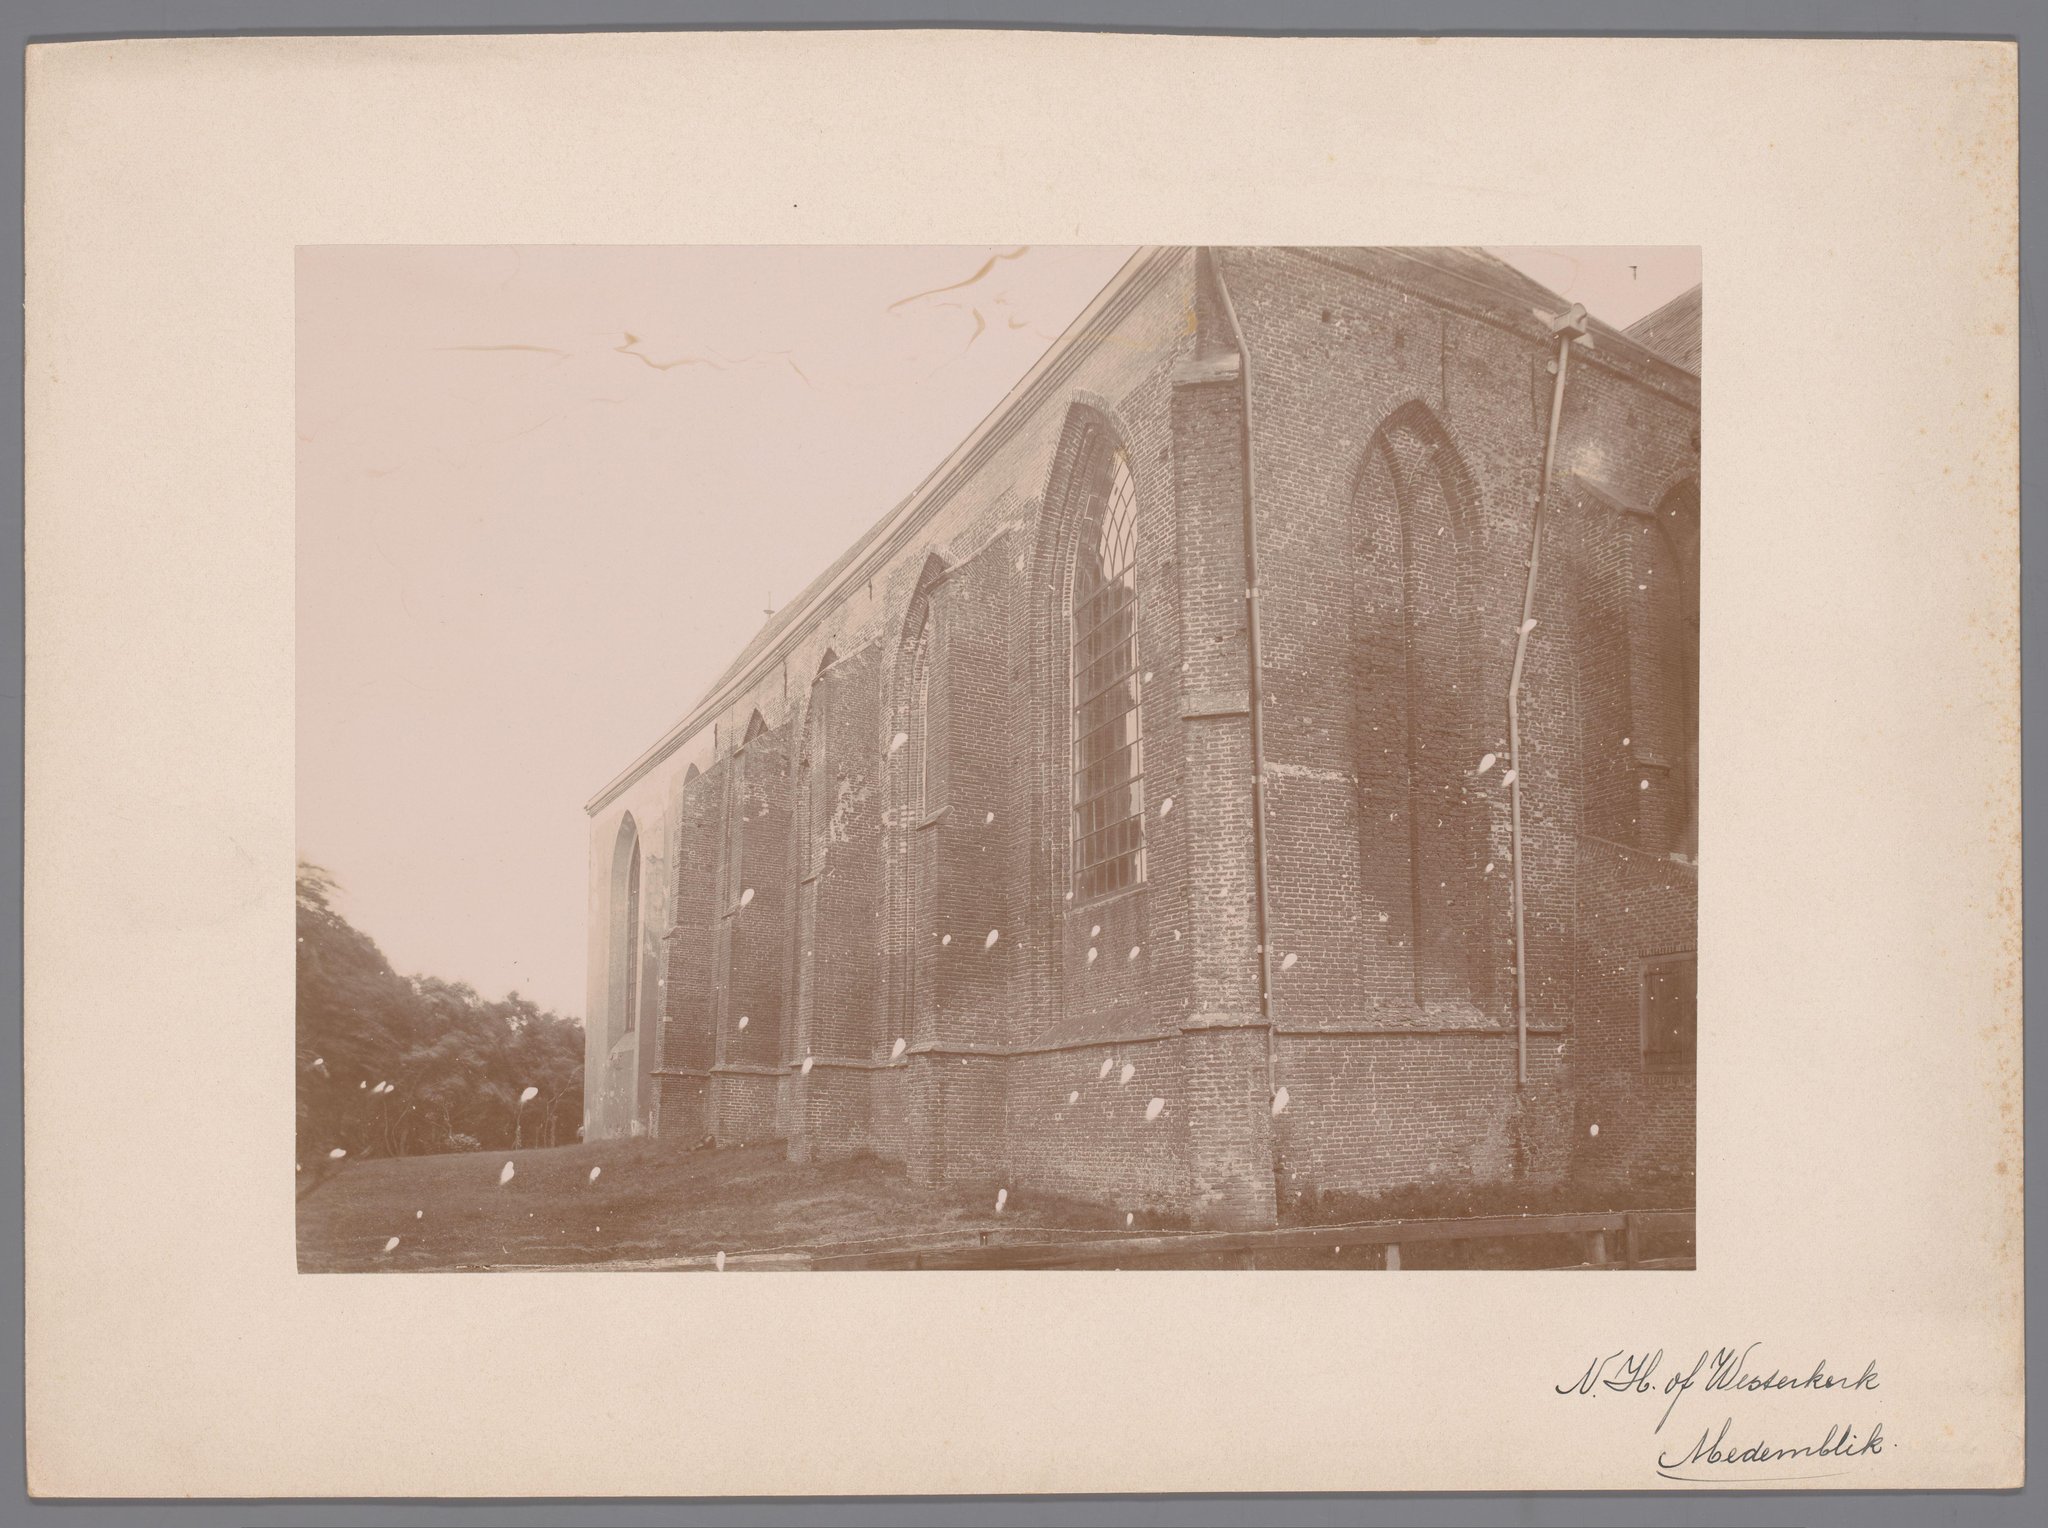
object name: photograph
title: Gezicht op de Westerkerk te Medemblik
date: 1898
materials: cardboard, photographic support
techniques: gelatin silver print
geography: medemblik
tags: church (exterior)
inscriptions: annotation: ‘Noordvoorzijde der NH Kerk te Medemblik Juli 1898 (N.H.)’, annotation: ‘N.H. of Westerkerk/ Medemblik’